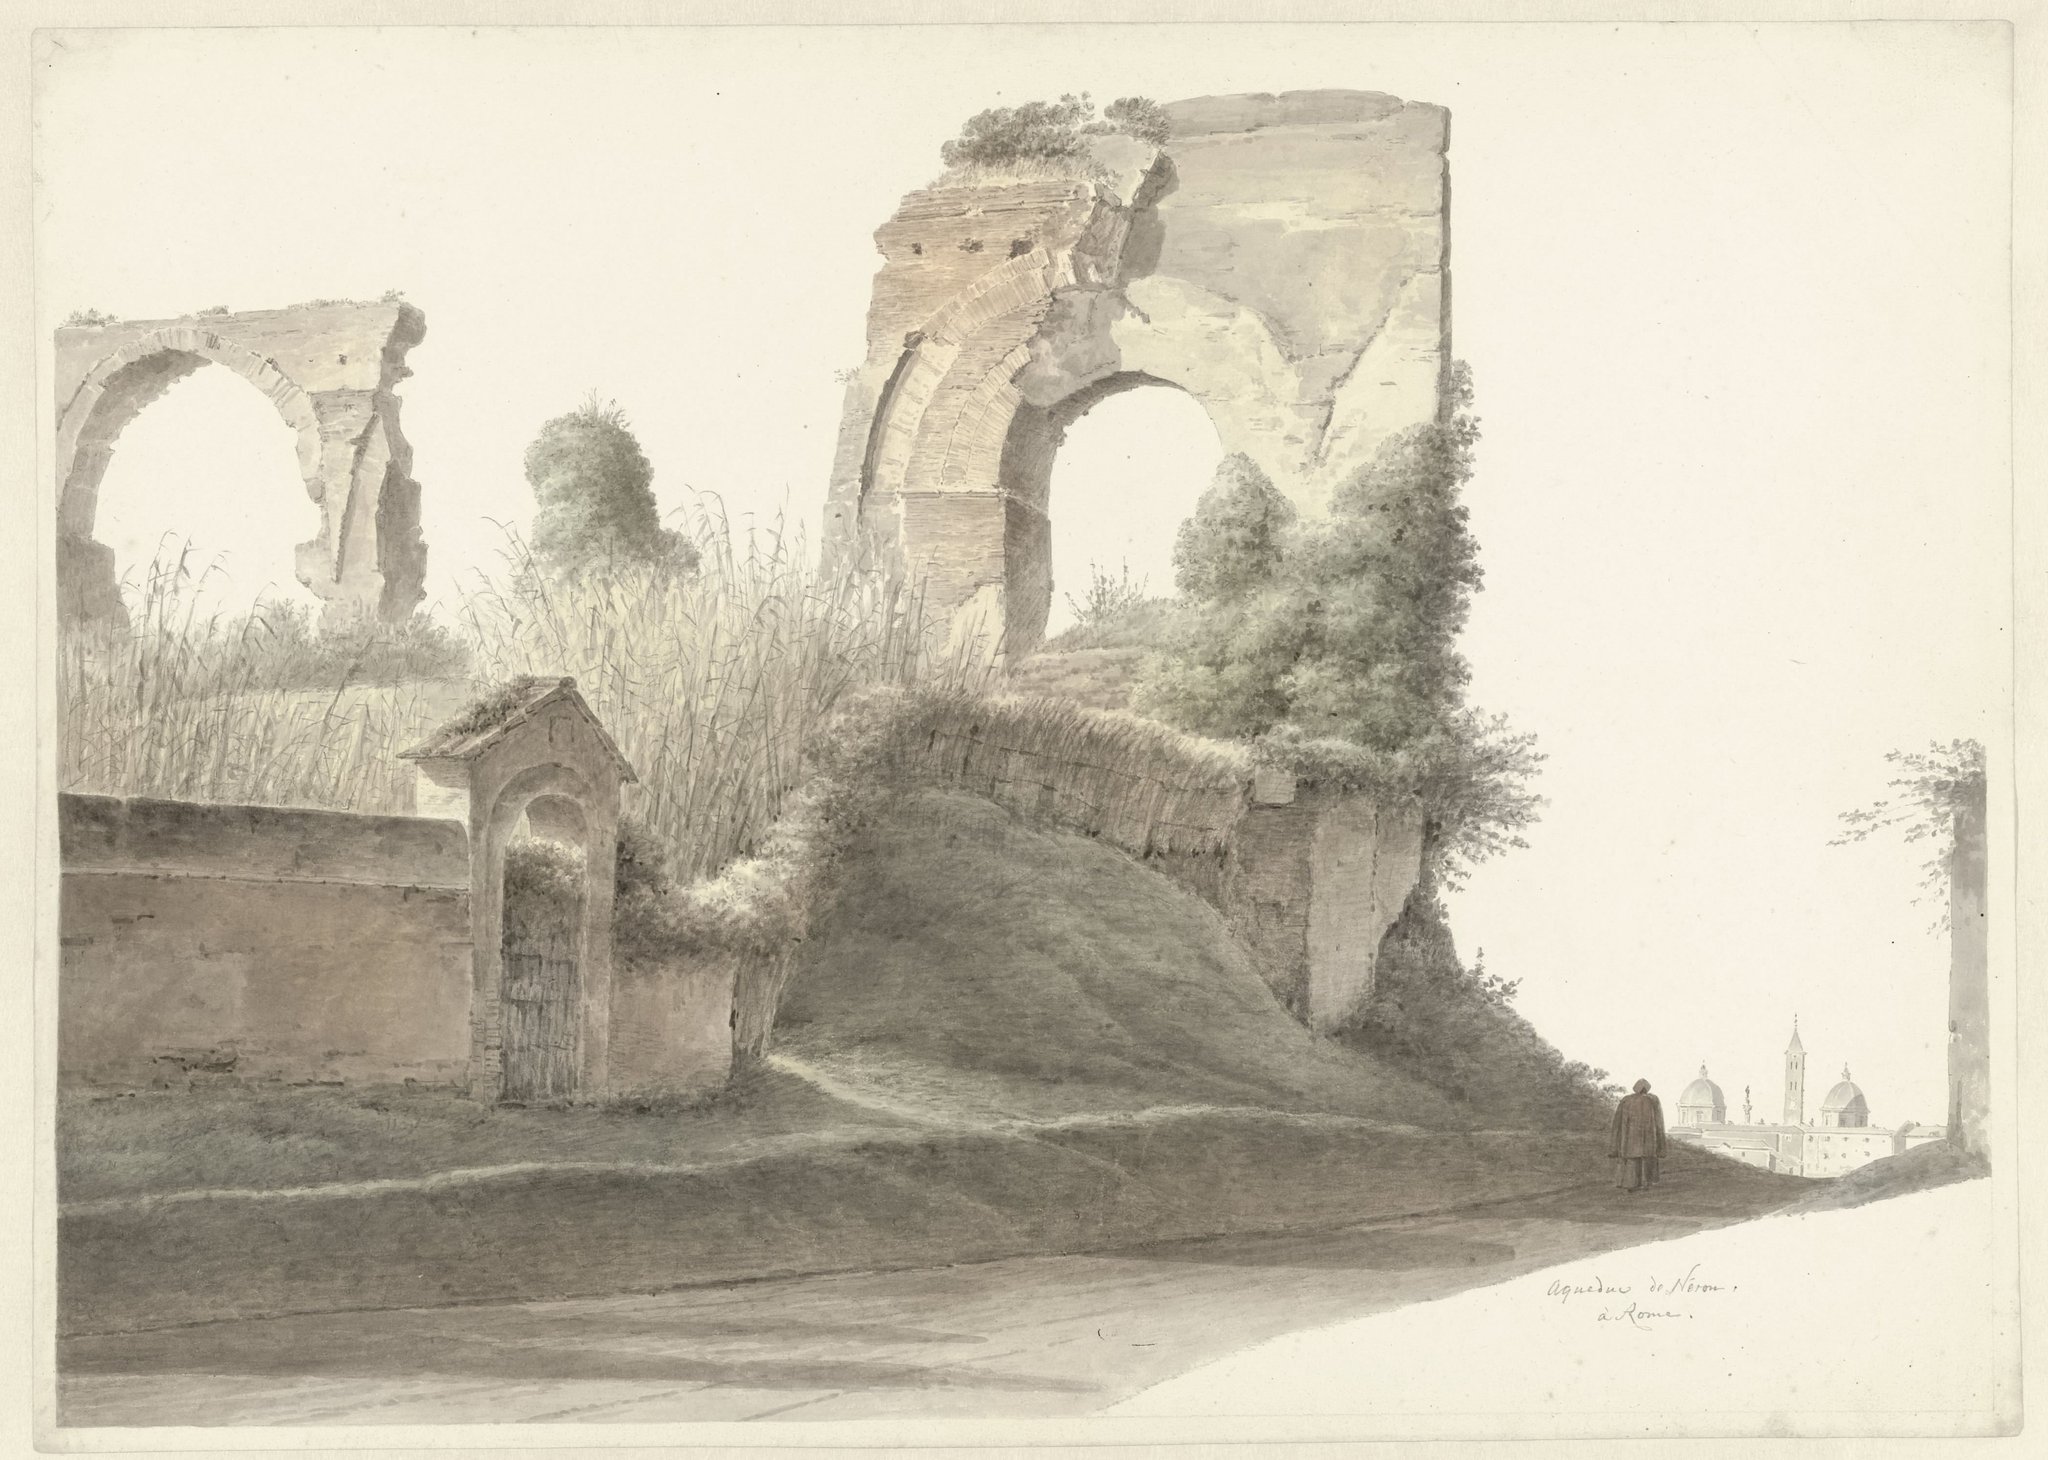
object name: drawing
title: Nero’s Aqueduct in Rome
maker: josephus augustus knip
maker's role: draughtsman, painter, print maker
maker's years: 1777-1847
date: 1809-1812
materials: graphite, paper, watercolor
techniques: brush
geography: italy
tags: ruin of a building ~ architecture, landscape with ruins, aqueduct (~ water supply), rome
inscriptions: inscription: ‘Aqueduc de Néron. / à Rome’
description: Knip seems here to have drawn a section of the aqueduct that even now is still known as the Aquadotto Neroniano, the ancient Aqua Neronis. It is located not far from the basilica of Santa Maria Maggiore, whose two domes and tall bell tower Knip included in the right background of his drawing.